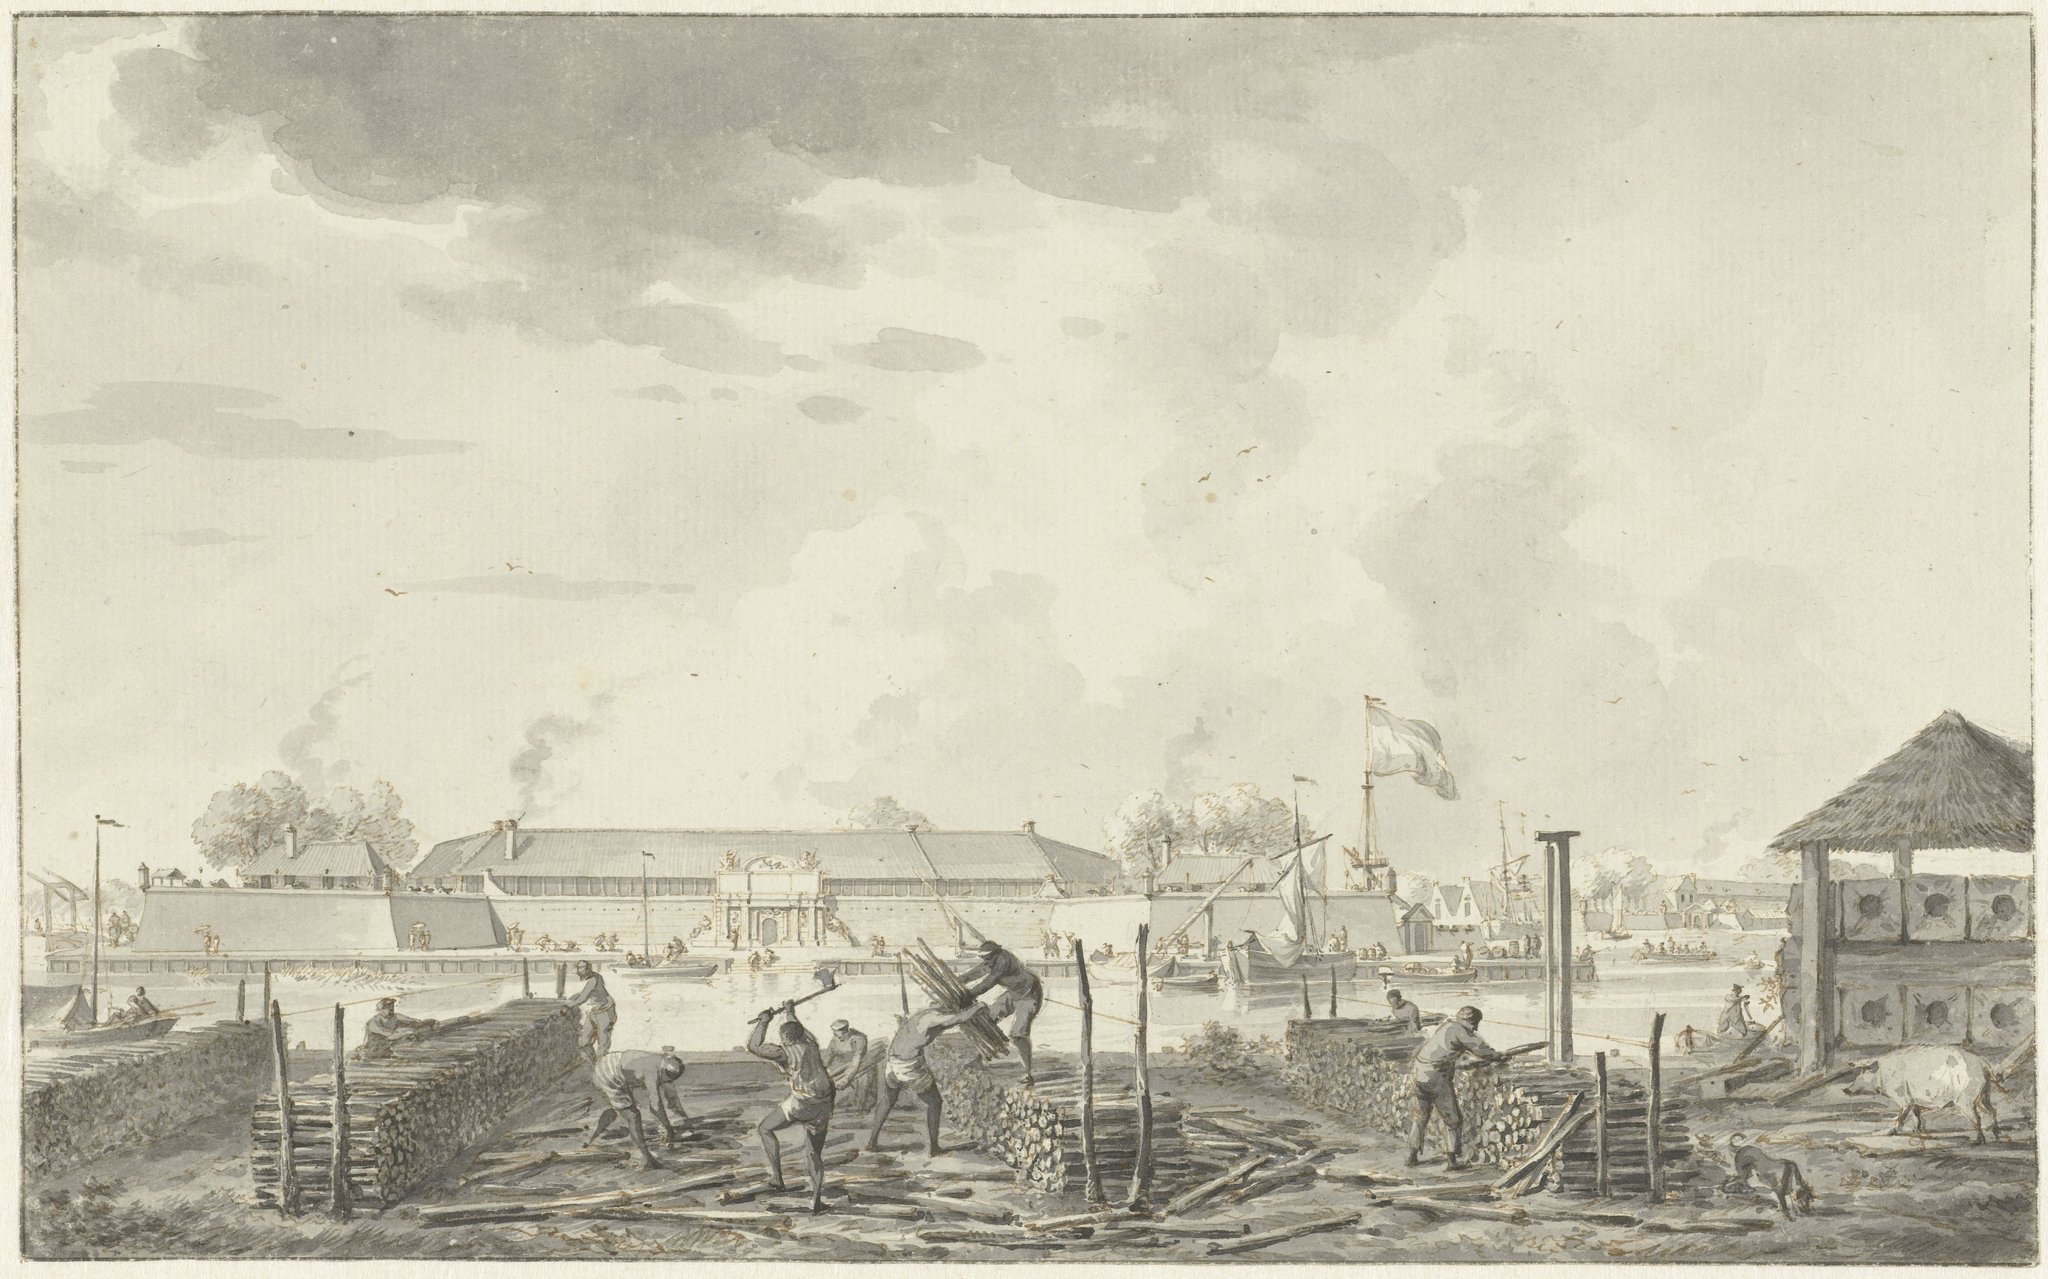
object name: drawing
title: Het kasteel te Batavia, gezien vanaf de Houtkrap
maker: hendrik kobell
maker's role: draughtsman, painter, print maker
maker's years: 1751-1779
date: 1761-1779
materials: chalk, ink, paper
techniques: brush, pen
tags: fortress, public road, indonesia